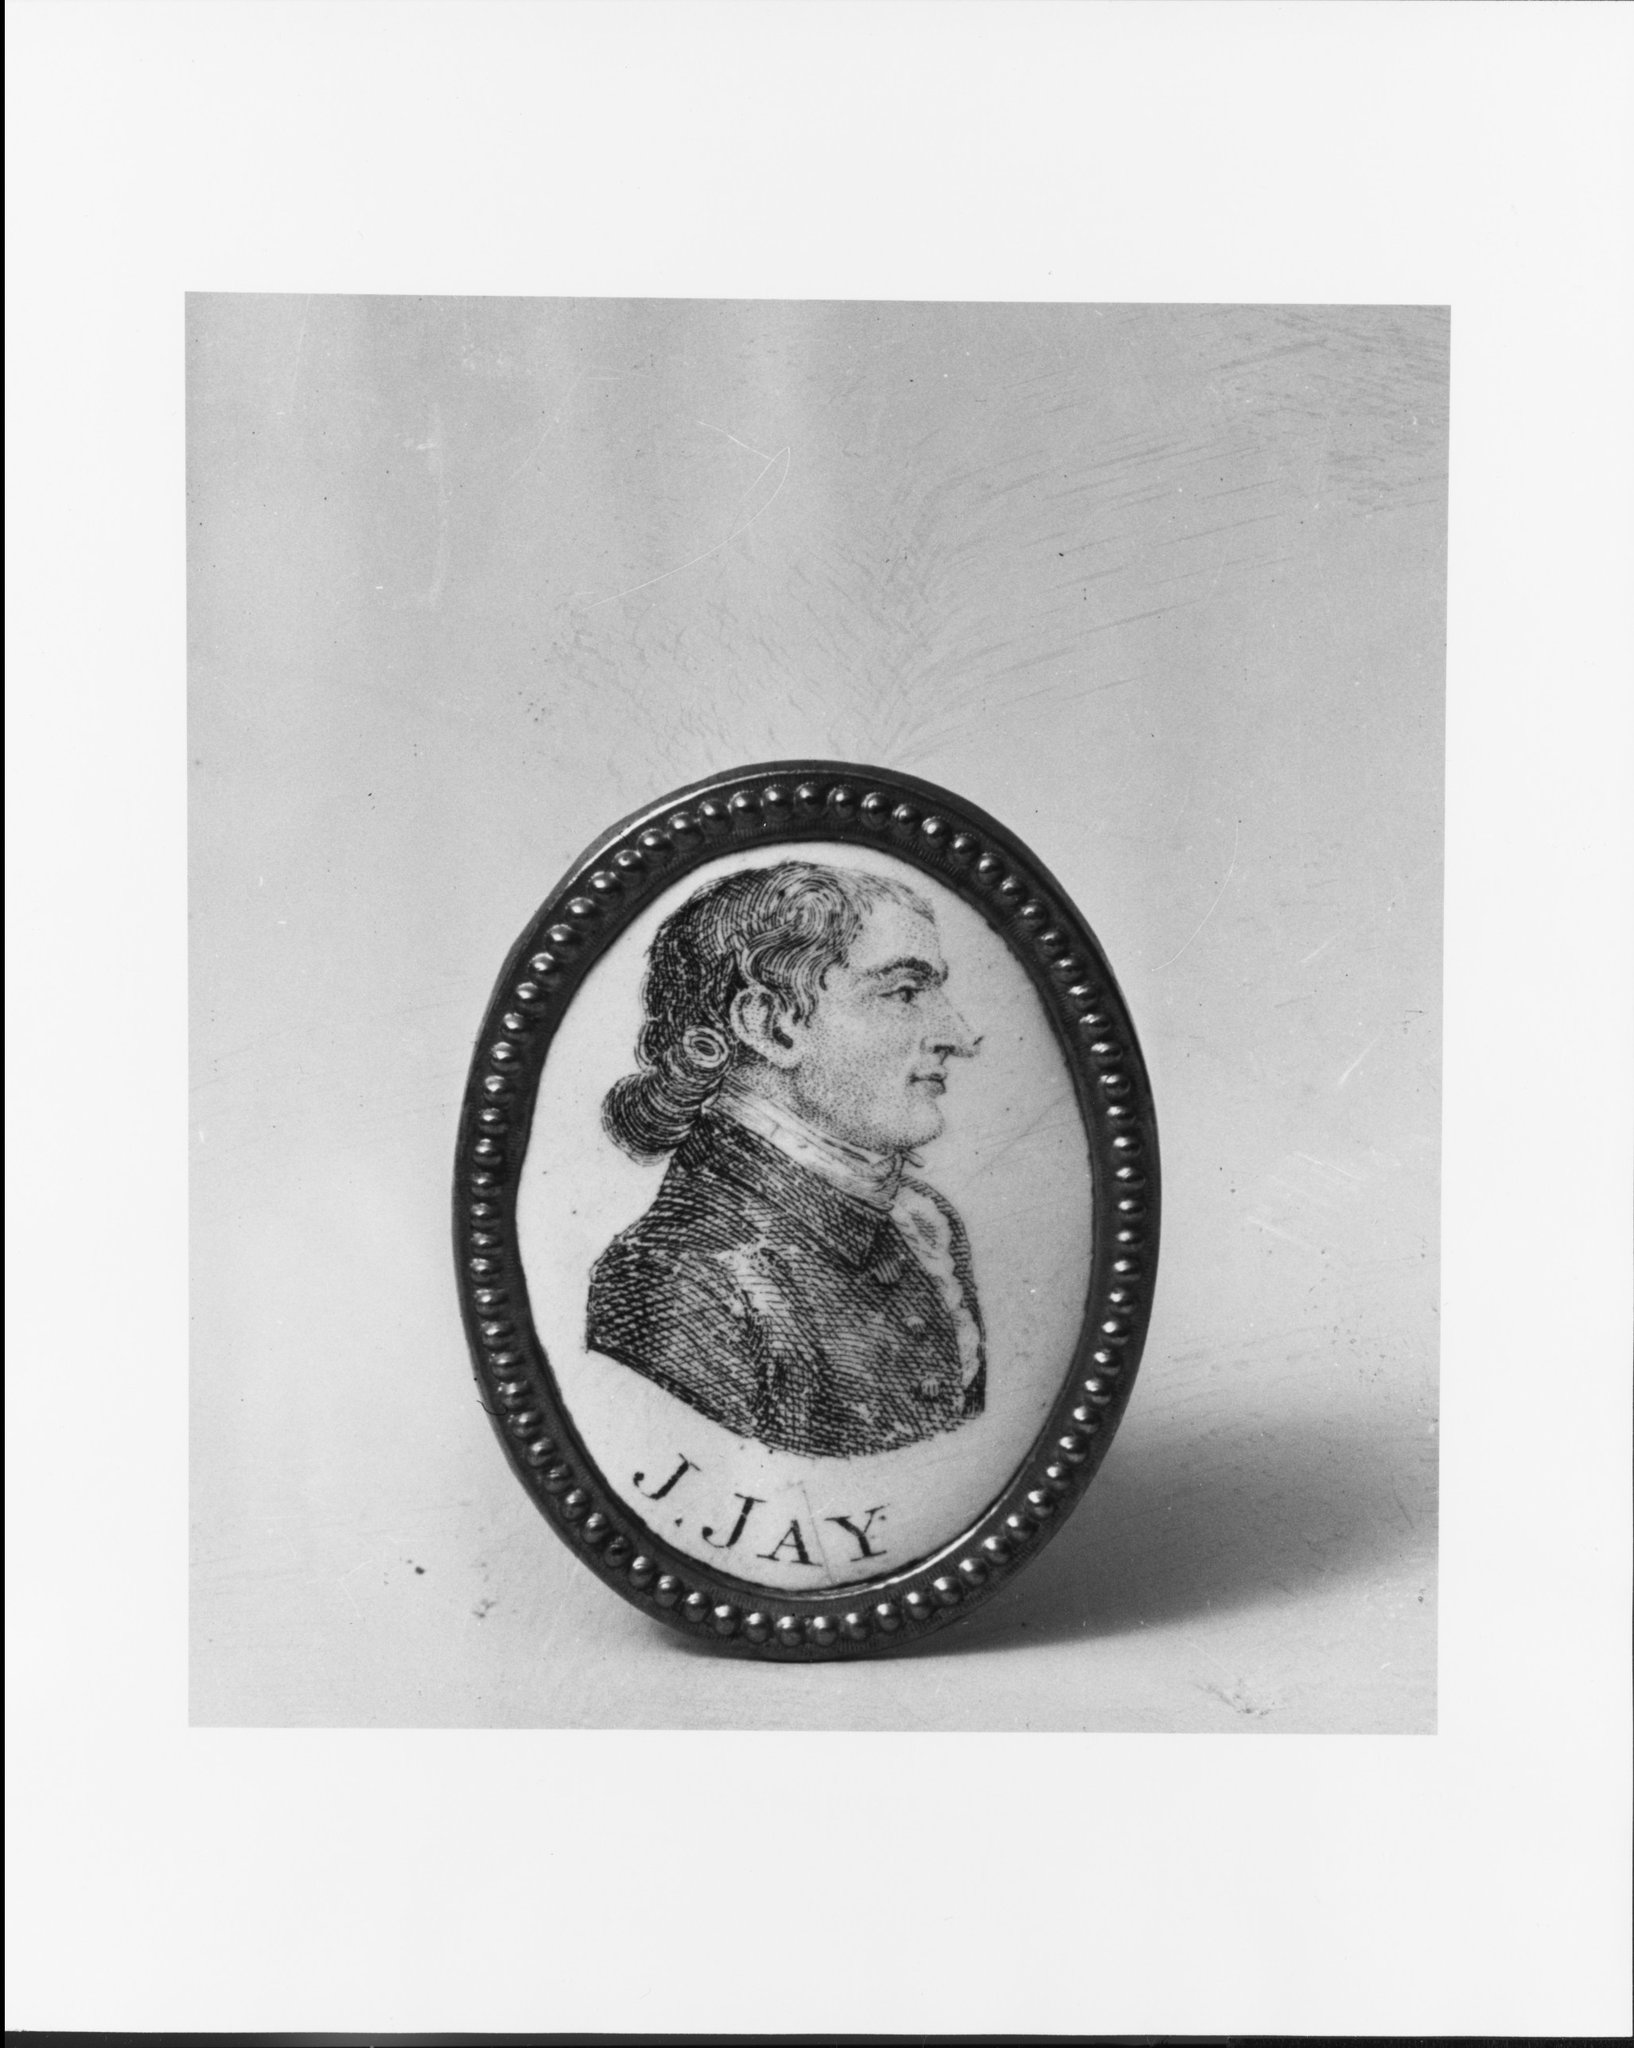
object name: pin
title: Cloak Pin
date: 1750-1800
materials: brass, copper, enamel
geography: england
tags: men,portraits,profiles